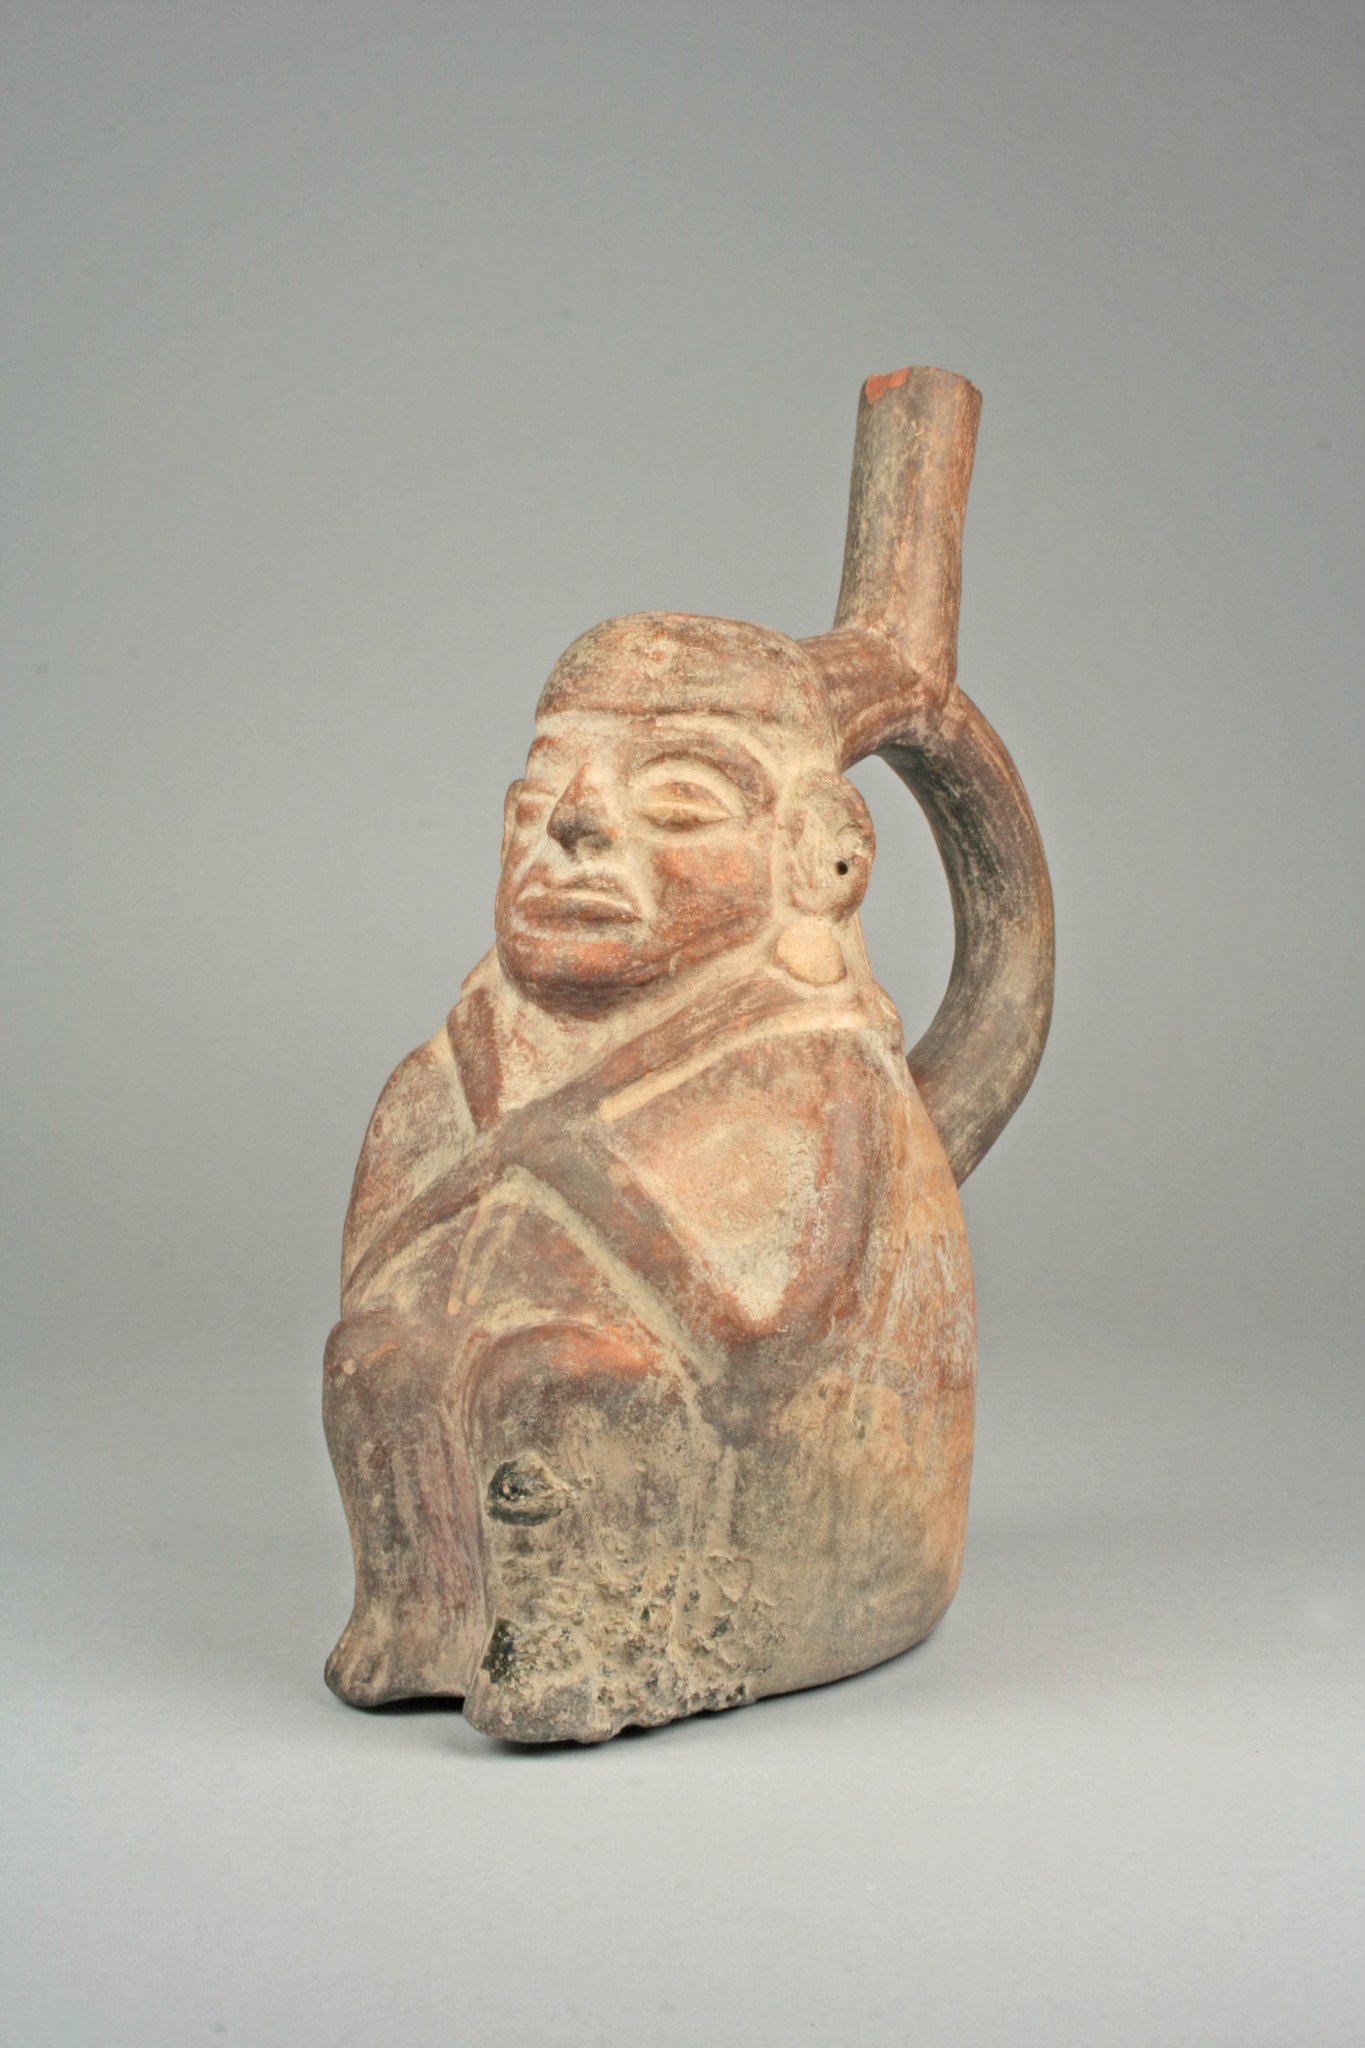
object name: bottle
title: Stirrup Spout Bottle with Figure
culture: moche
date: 401-700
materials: ceramic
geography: peru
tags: human figures